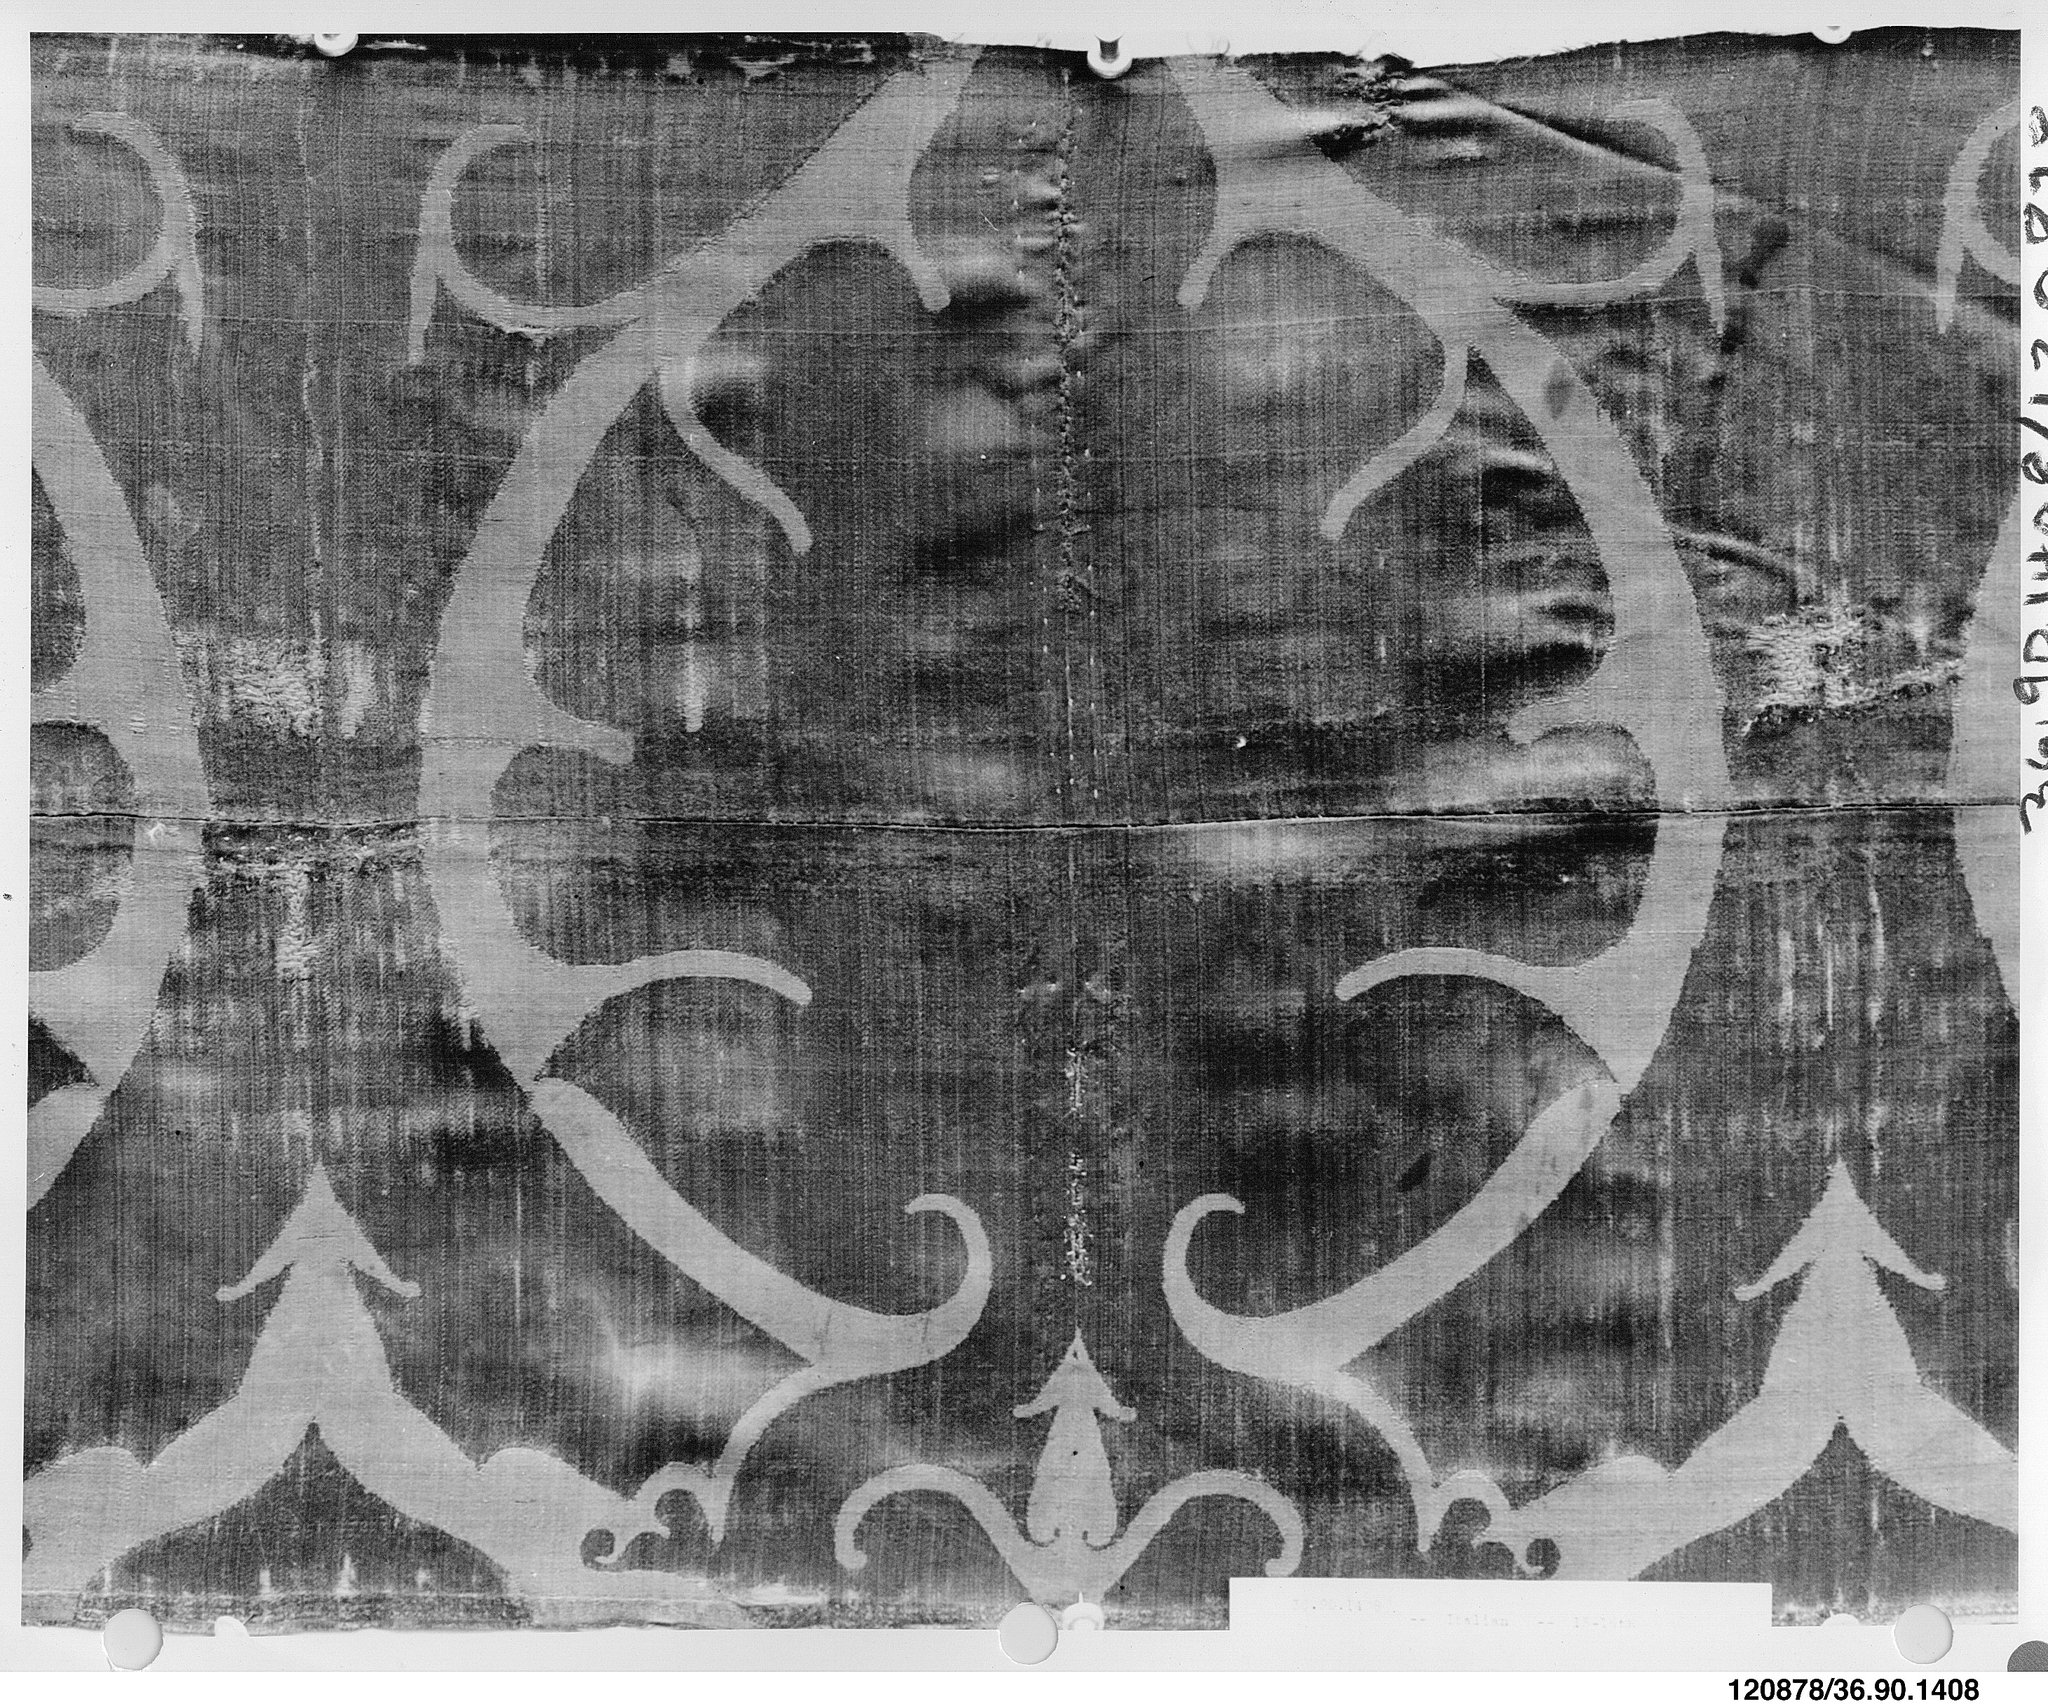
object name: piece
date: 1401-1600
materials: silk